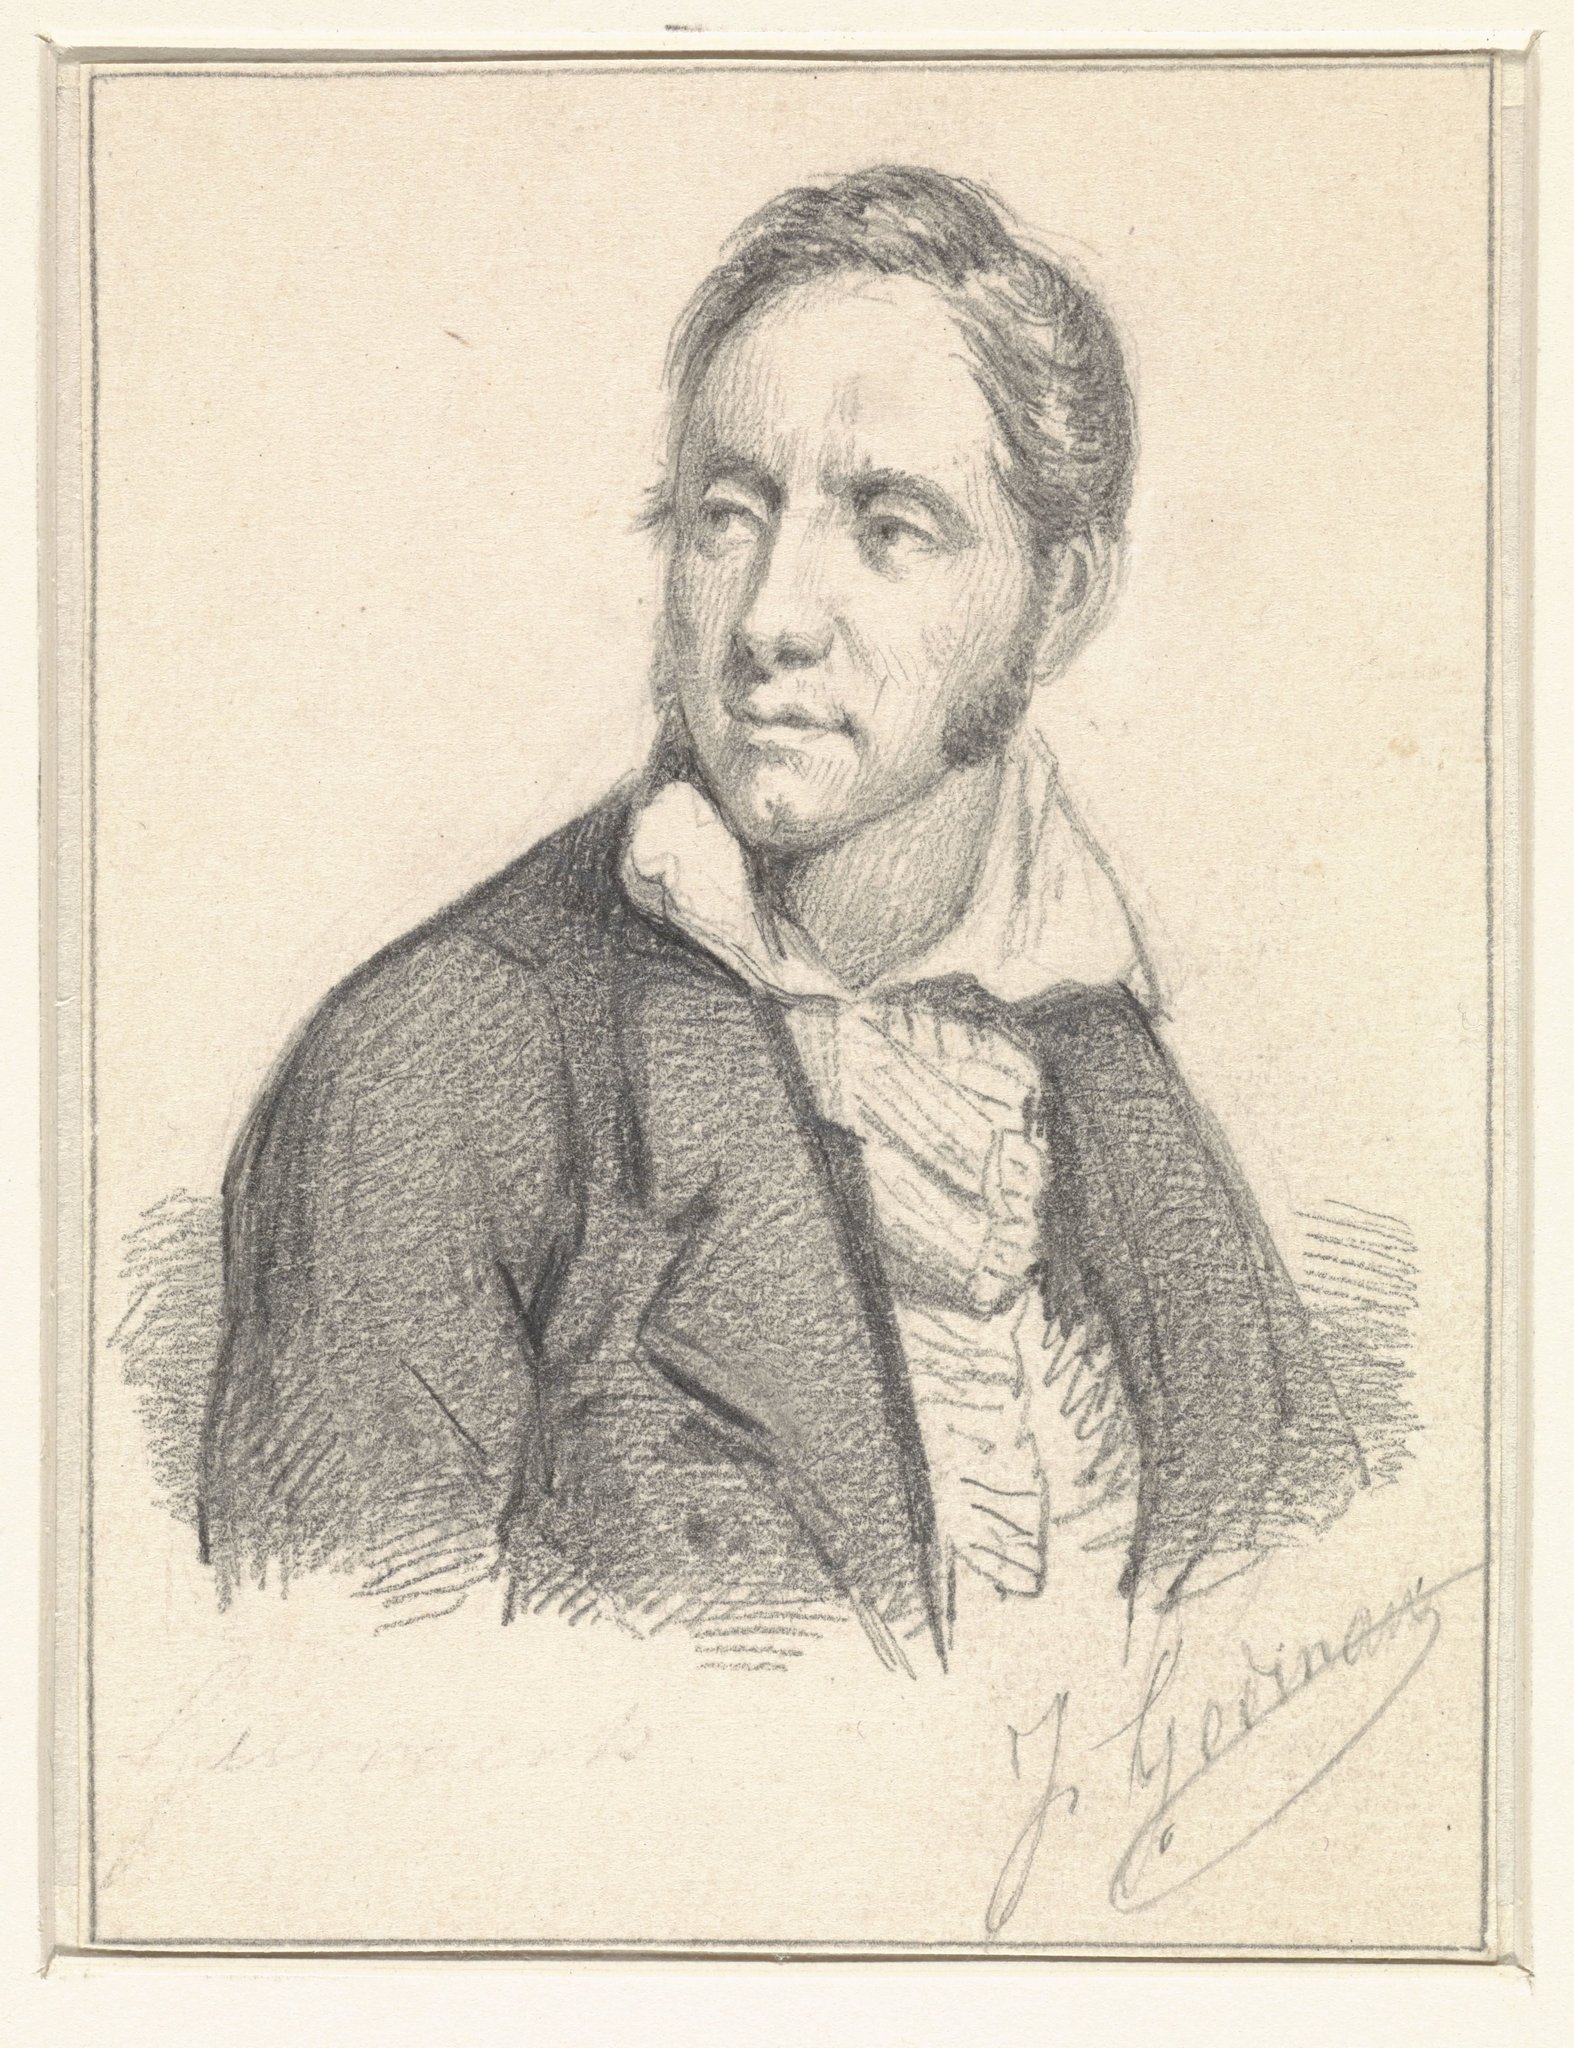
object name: design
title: Portret van Josef Geirnaert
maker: jacobus ludovicus godinau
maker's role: draughtsman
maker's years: 1811-1873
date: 1840-1842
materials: paper, pencil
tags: jozef geirnaert, historical persons, portrait, self-portrait of painter, portrait, self-portrait of artist, portrait, self-portrait of draughtsman